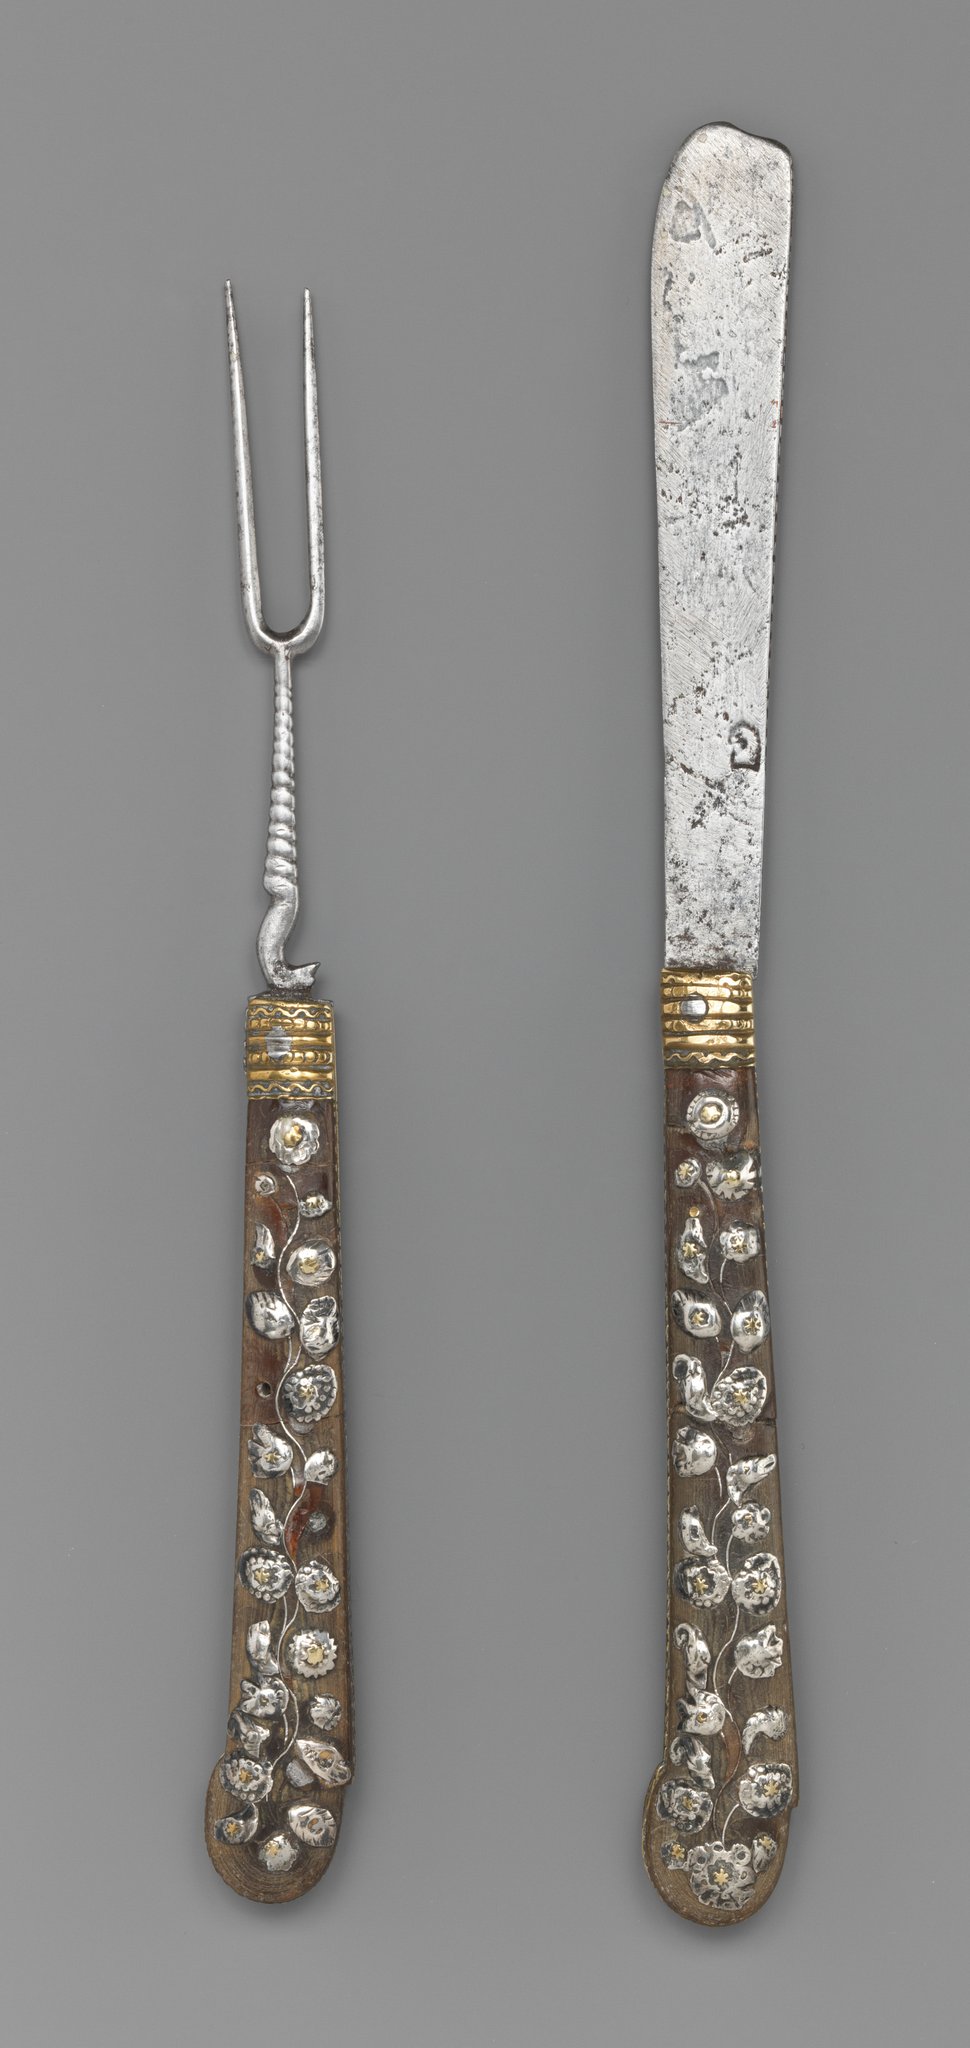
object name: folding knife and fork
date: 1701-1800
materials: brass, horn, silver, steel